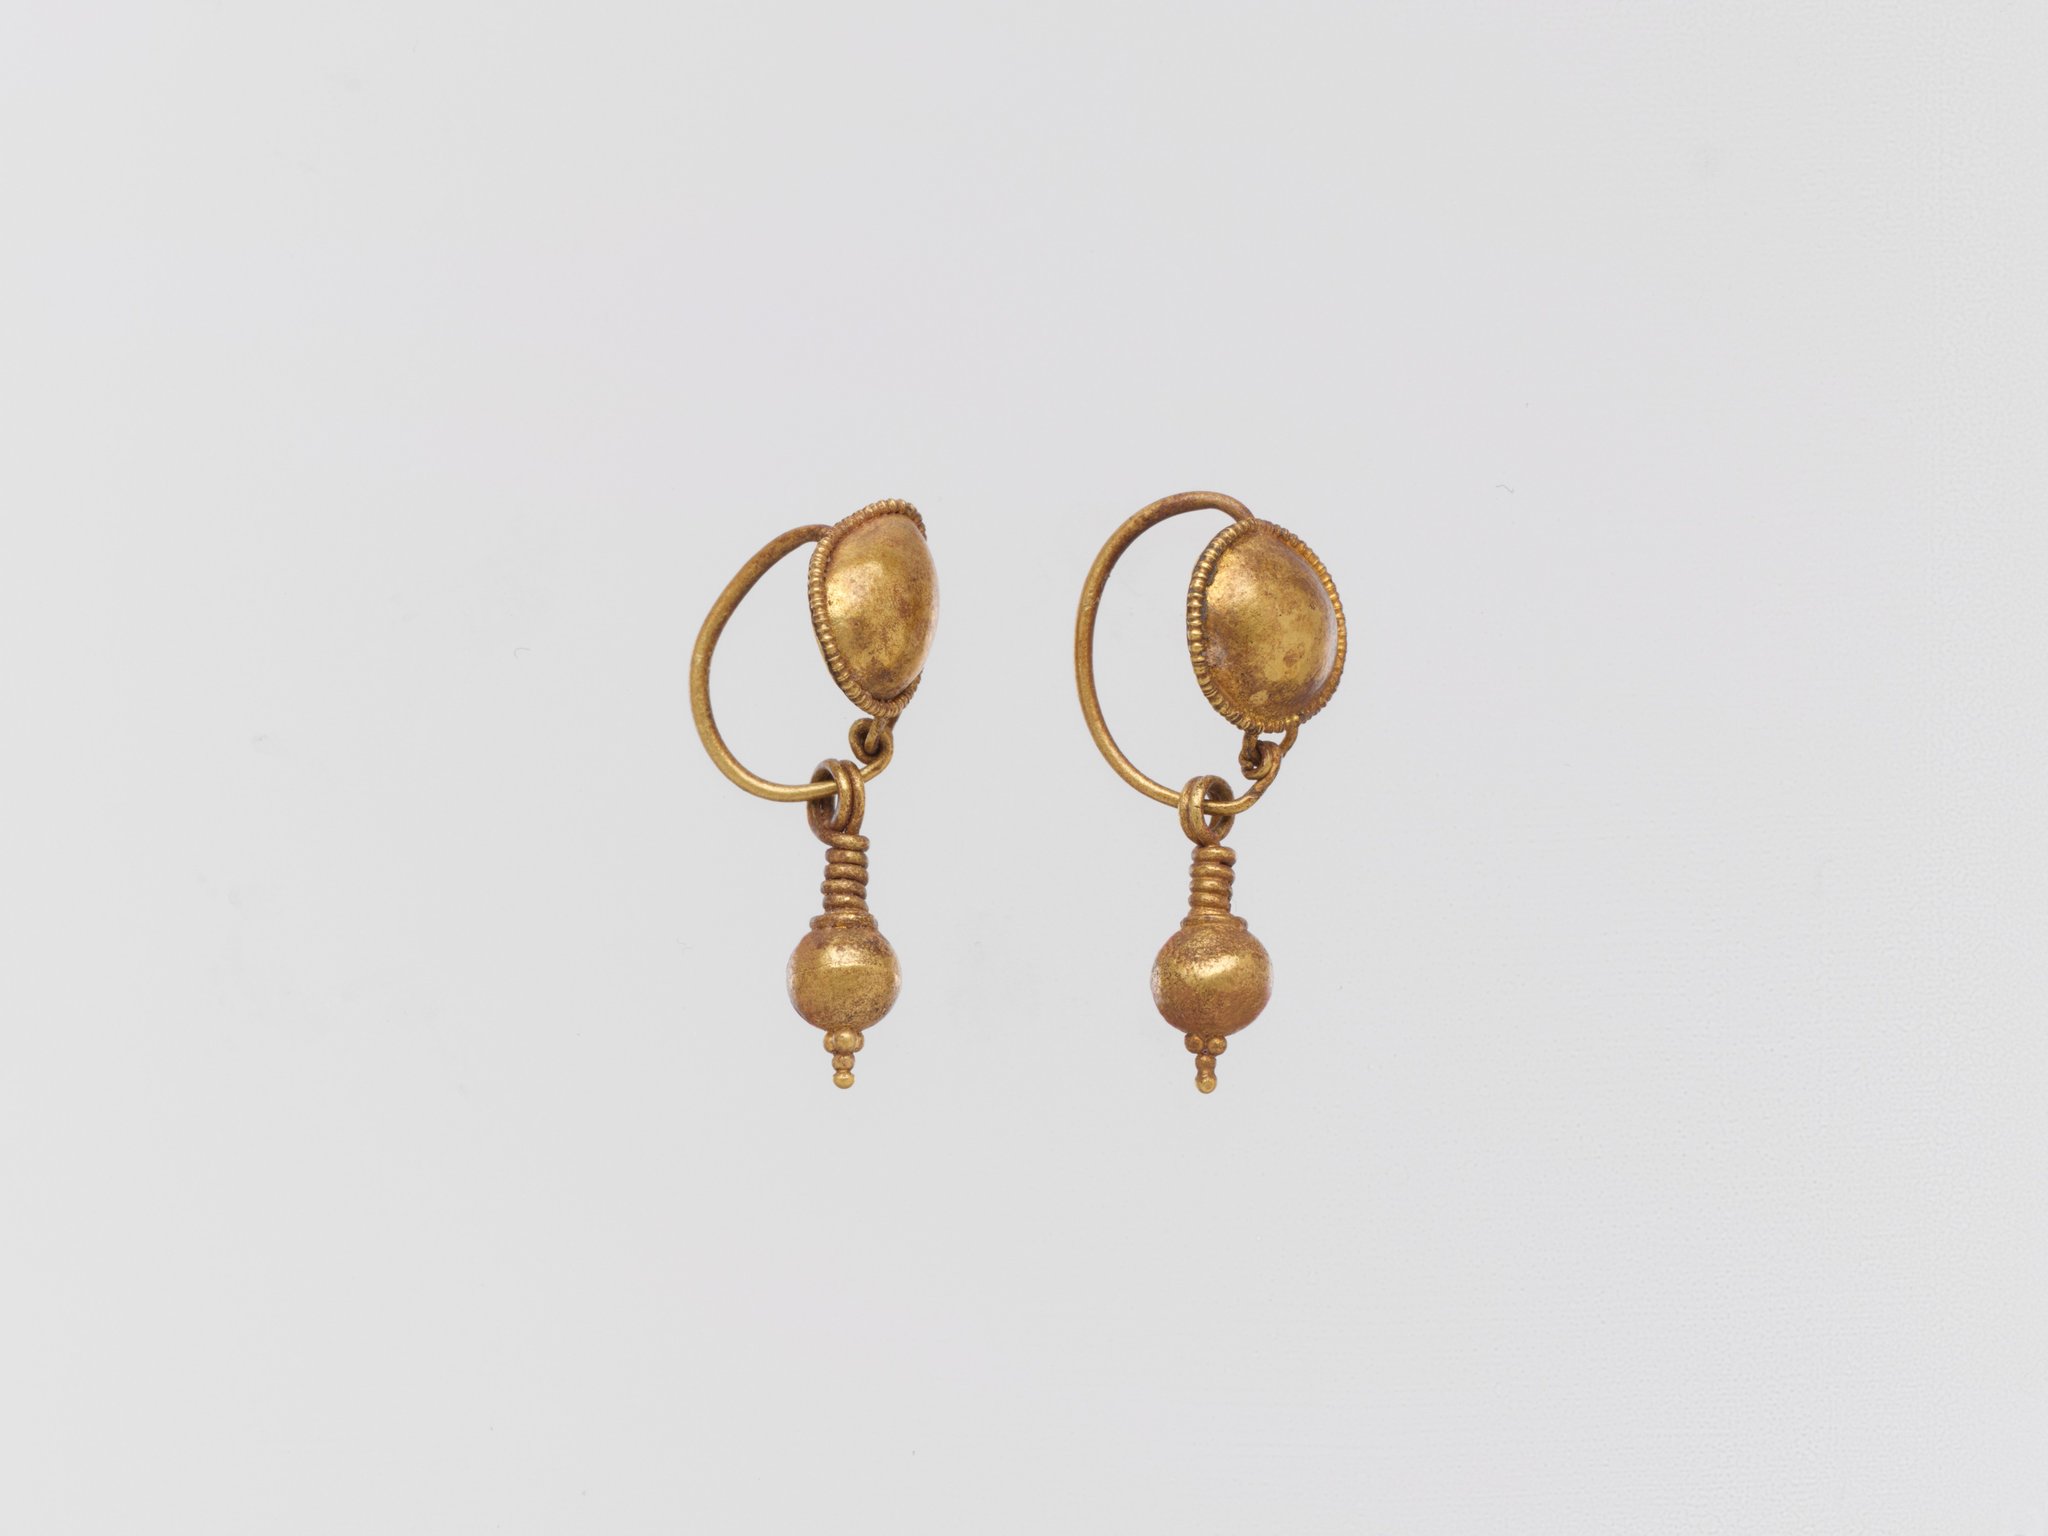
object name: earring with pendant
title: Pair of gold earrings with disc and pendant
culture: roman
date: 101-200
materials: gold